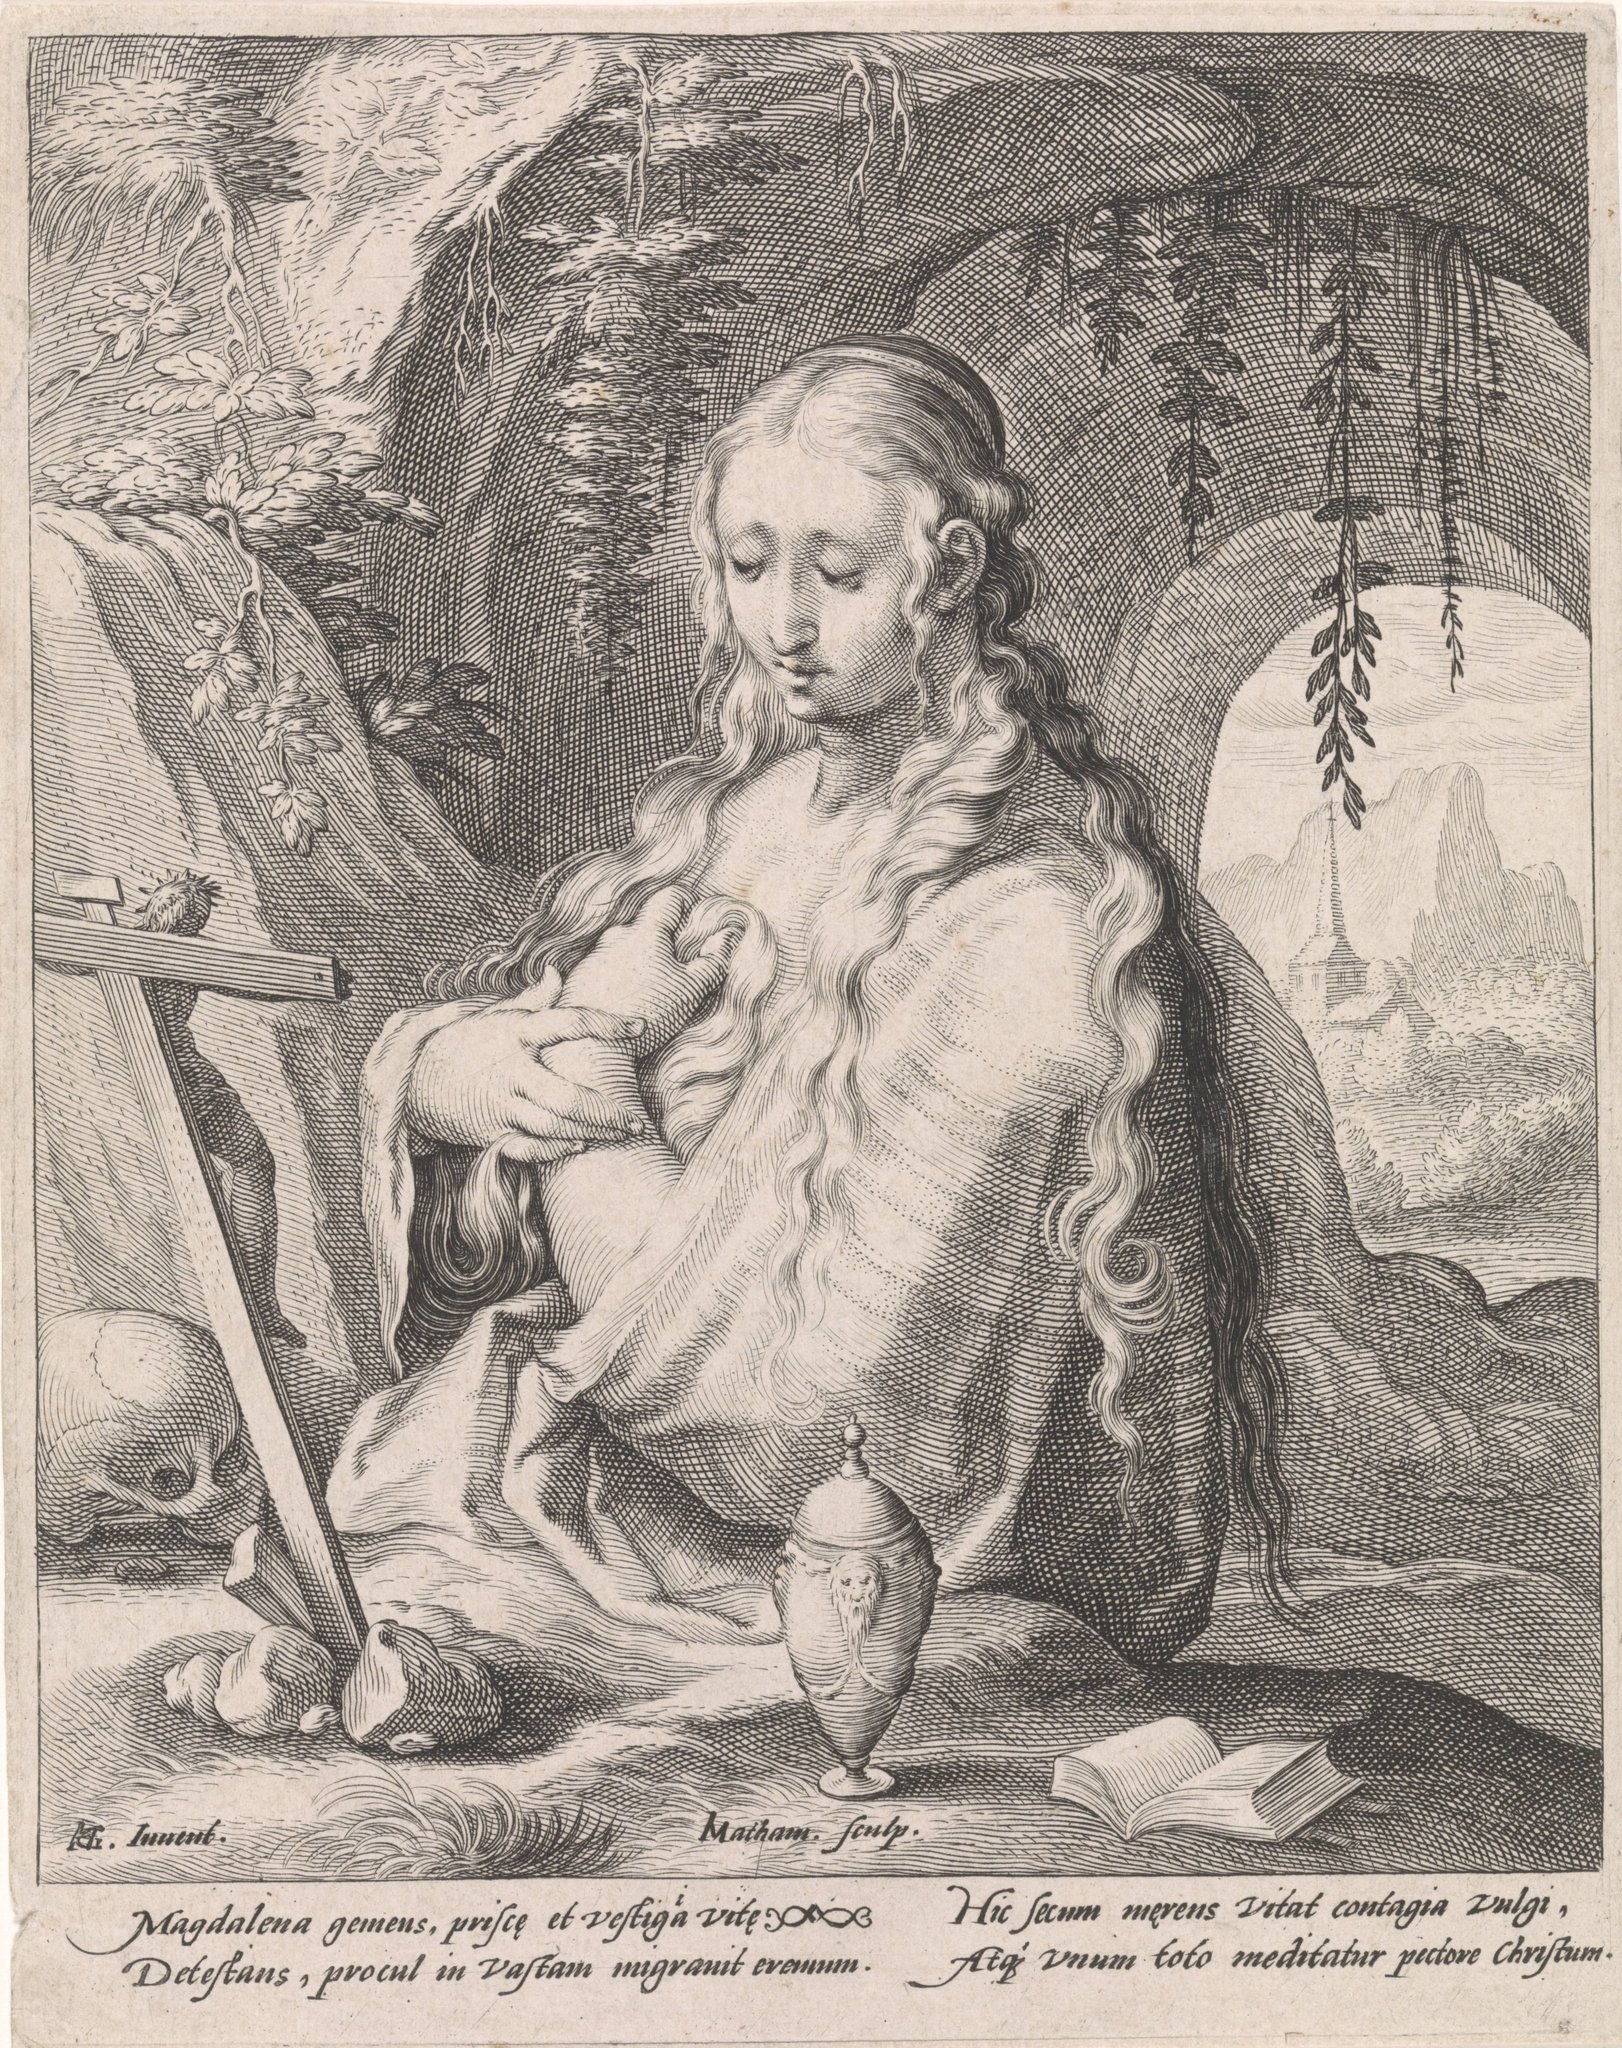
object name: print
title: Boetvaardige Maria Magdalena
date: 1588-1592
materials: paper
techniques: engraving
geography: haarlem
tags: the penitent st. mary magdalene (often before a cave, possibly at la sainte-baume hill): her long hair covers her (naked) body, she reads, meditates or raises her tear-filled eyes towards heaven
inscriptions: collector's mark: Lugt 2228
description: Maria Magdalena kijkend naar een crucifix in een deels begroeide grot. Op de voorgrond een vaas en een opengeslagen boek. Rechts op de achtergrond gezicht op bergachtig landschap met kerk. Onder de voorstelling vierregelige Latijnse tekst.